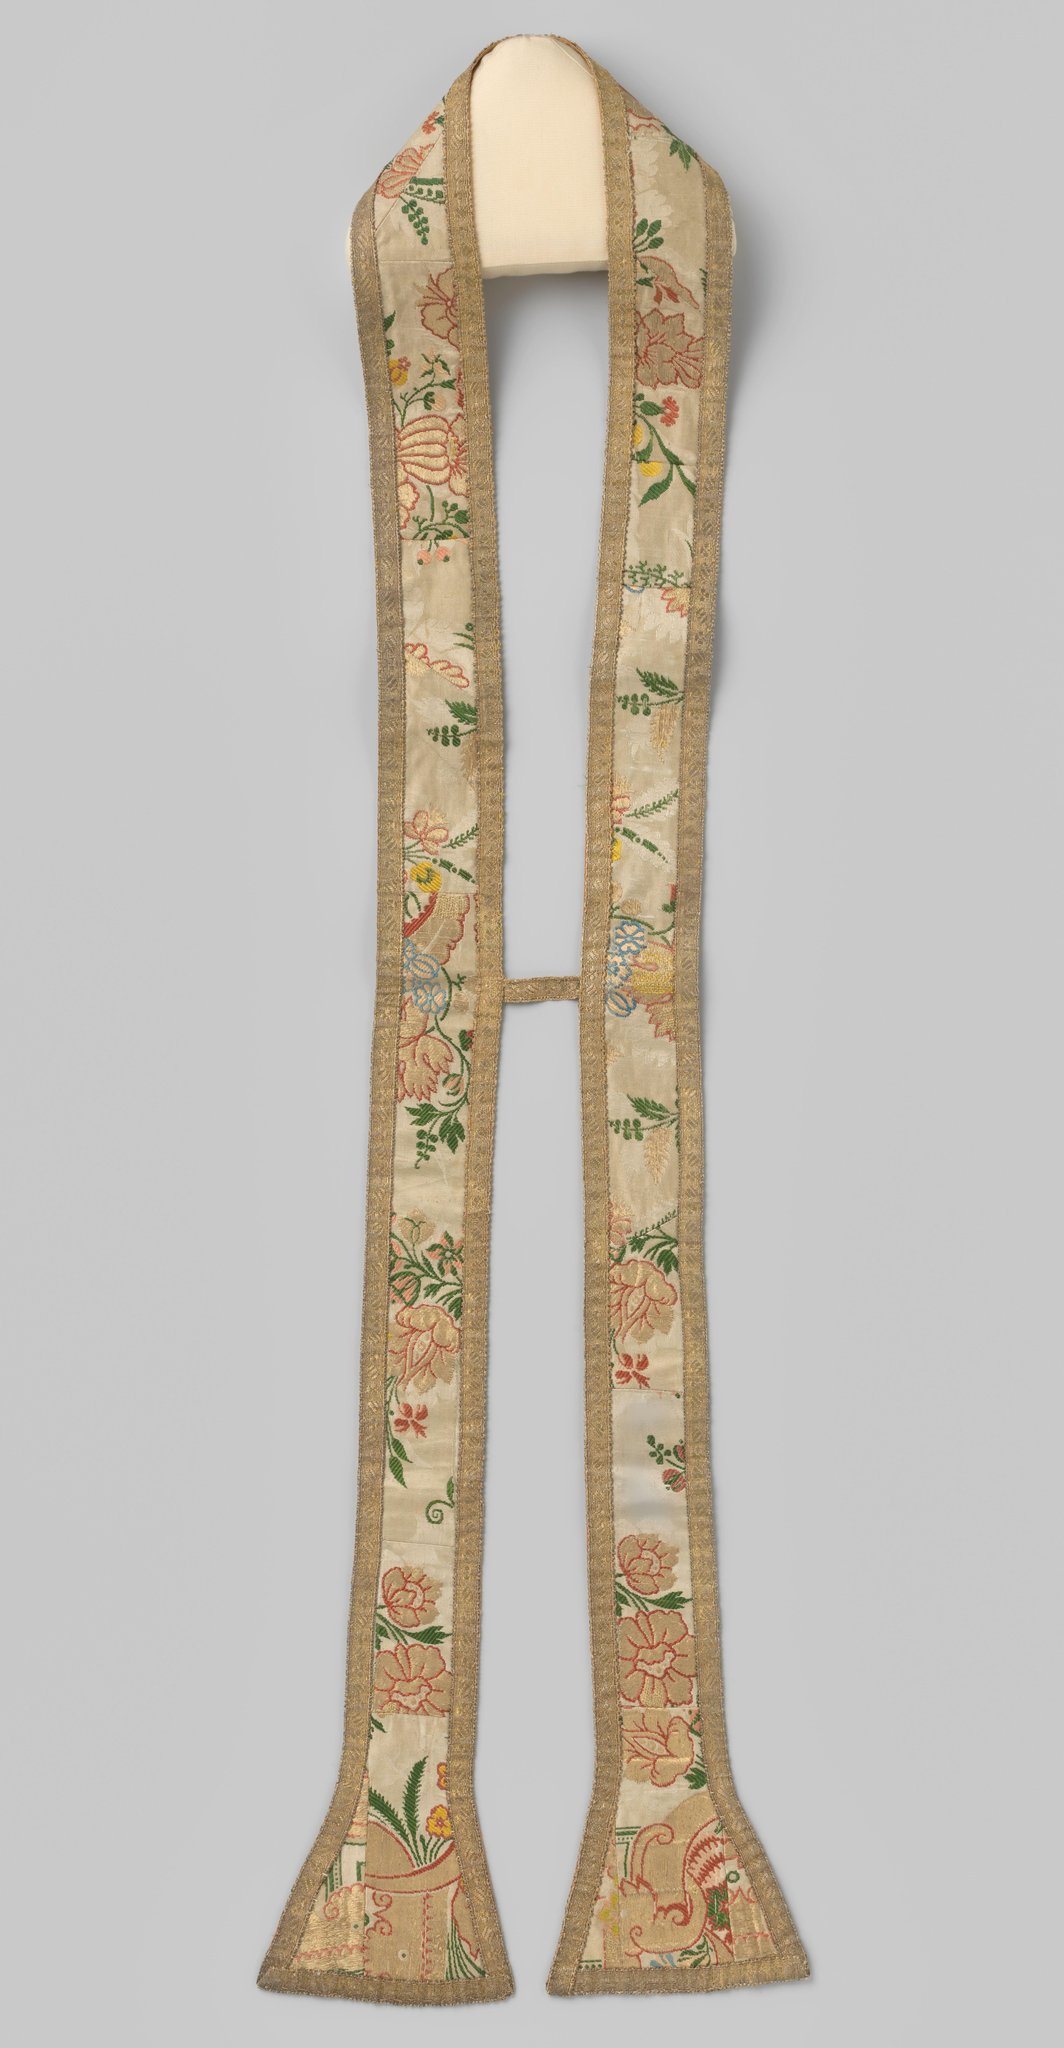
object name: stole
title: Stola van goudbrokaat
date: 1700-1725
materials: textile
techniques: brocade, embroidered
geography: france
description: Stola van goudbrocaat. De stola heeft schuine gaffeleinden (van de akoliet). Bij de stola hoort een stola met invnr. BK-1972-1-E. Beide stola's horen bij negen kerkelijke weefsels met borduurwerk met invnrs. BK-1972-1-A t/m BK-1972-1-I en een niet bijbehorende bijbehorende beurs met invnr. BK-1972-1-J.